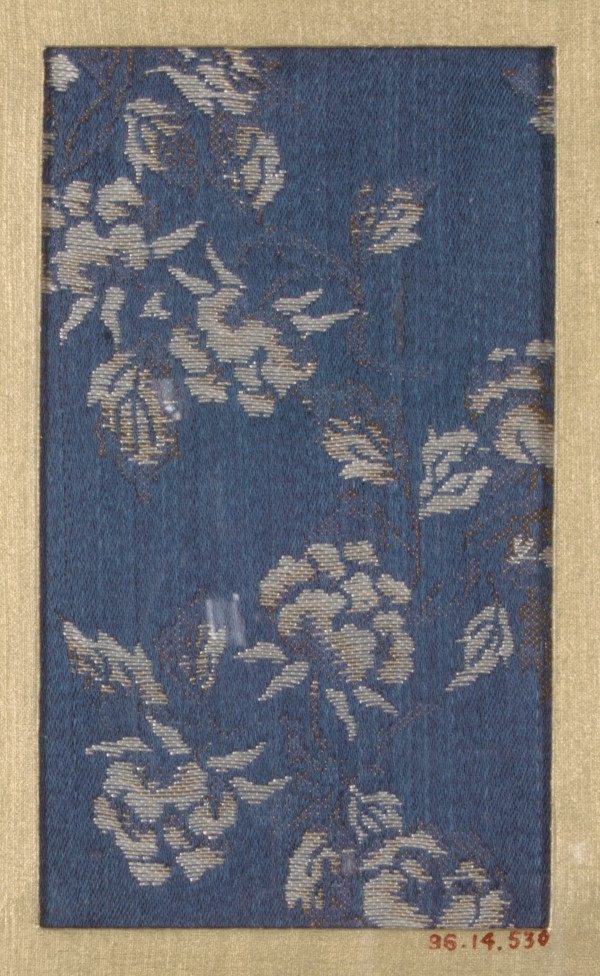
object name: piece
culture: japanese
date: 1701-1900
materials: silk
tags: flowers